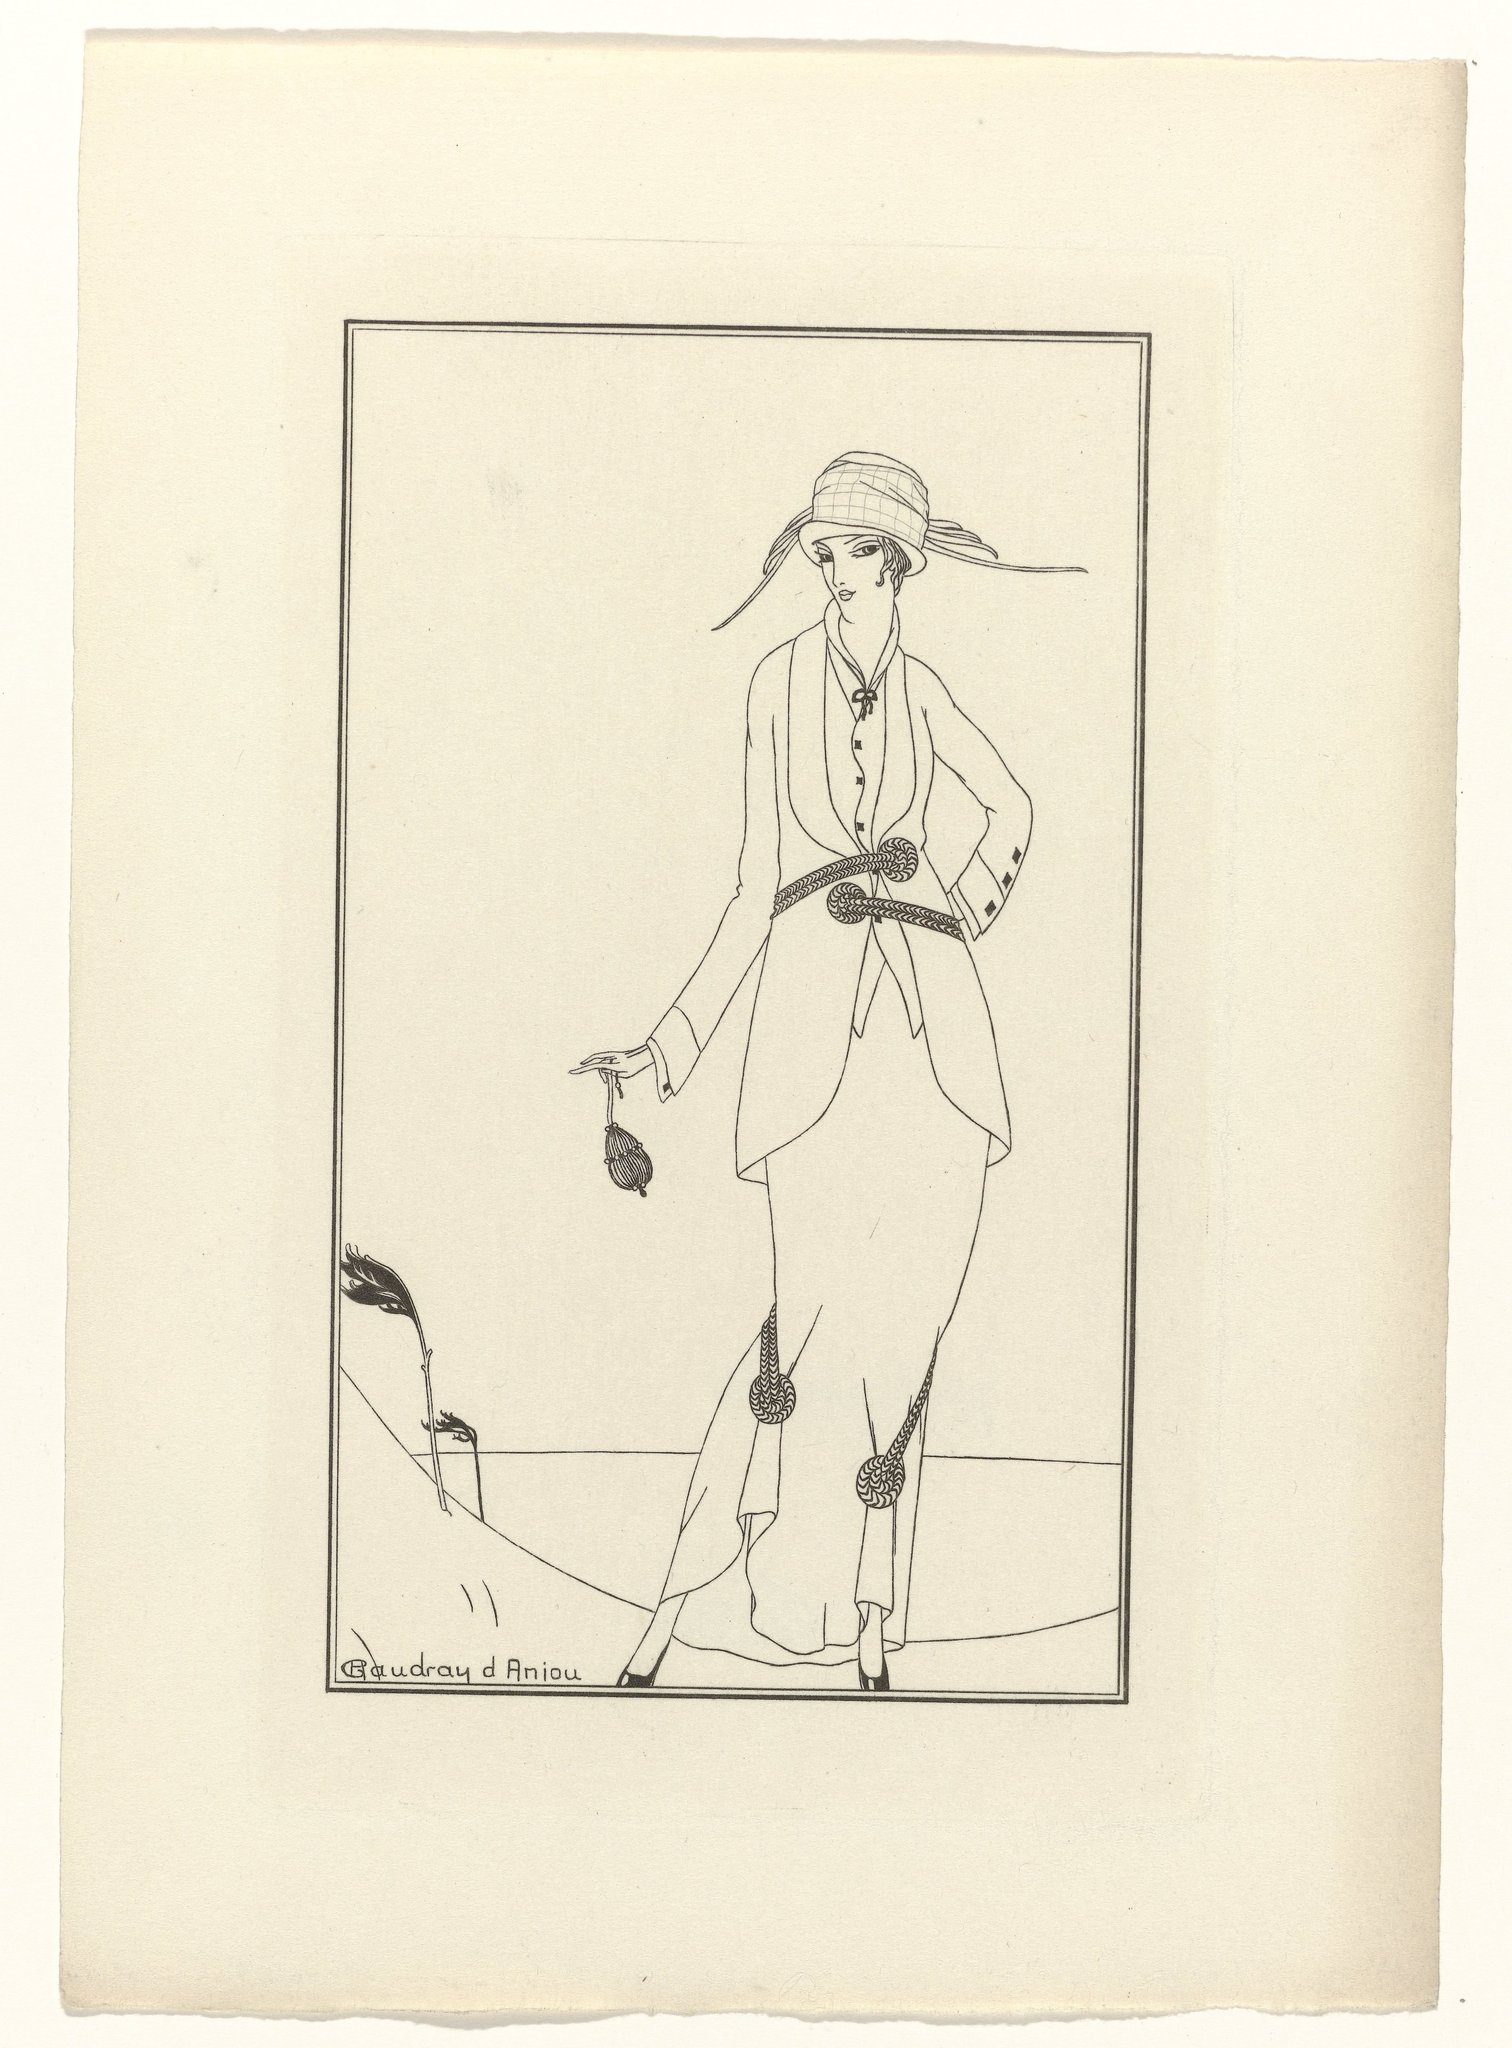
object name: fashion print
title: Journal des Dames et des Modes, Costumes Parisiens, 1914, No. 167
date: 1914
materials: paper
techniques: engraving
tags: ornamental parts of clothing (+ women's clothes), bag (handbag) (+ women's clothes), clothing for the upper part of the body (vest) (+ women's clothes), fashion plates, dress, gown (+ women's clothes)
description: Ensemble van serge versierd met koorden van zijde. Vest van tafzijde. Proefdruk van een prent uit het modetijdschrift Journal des Dames et des Modes (1912-1914).